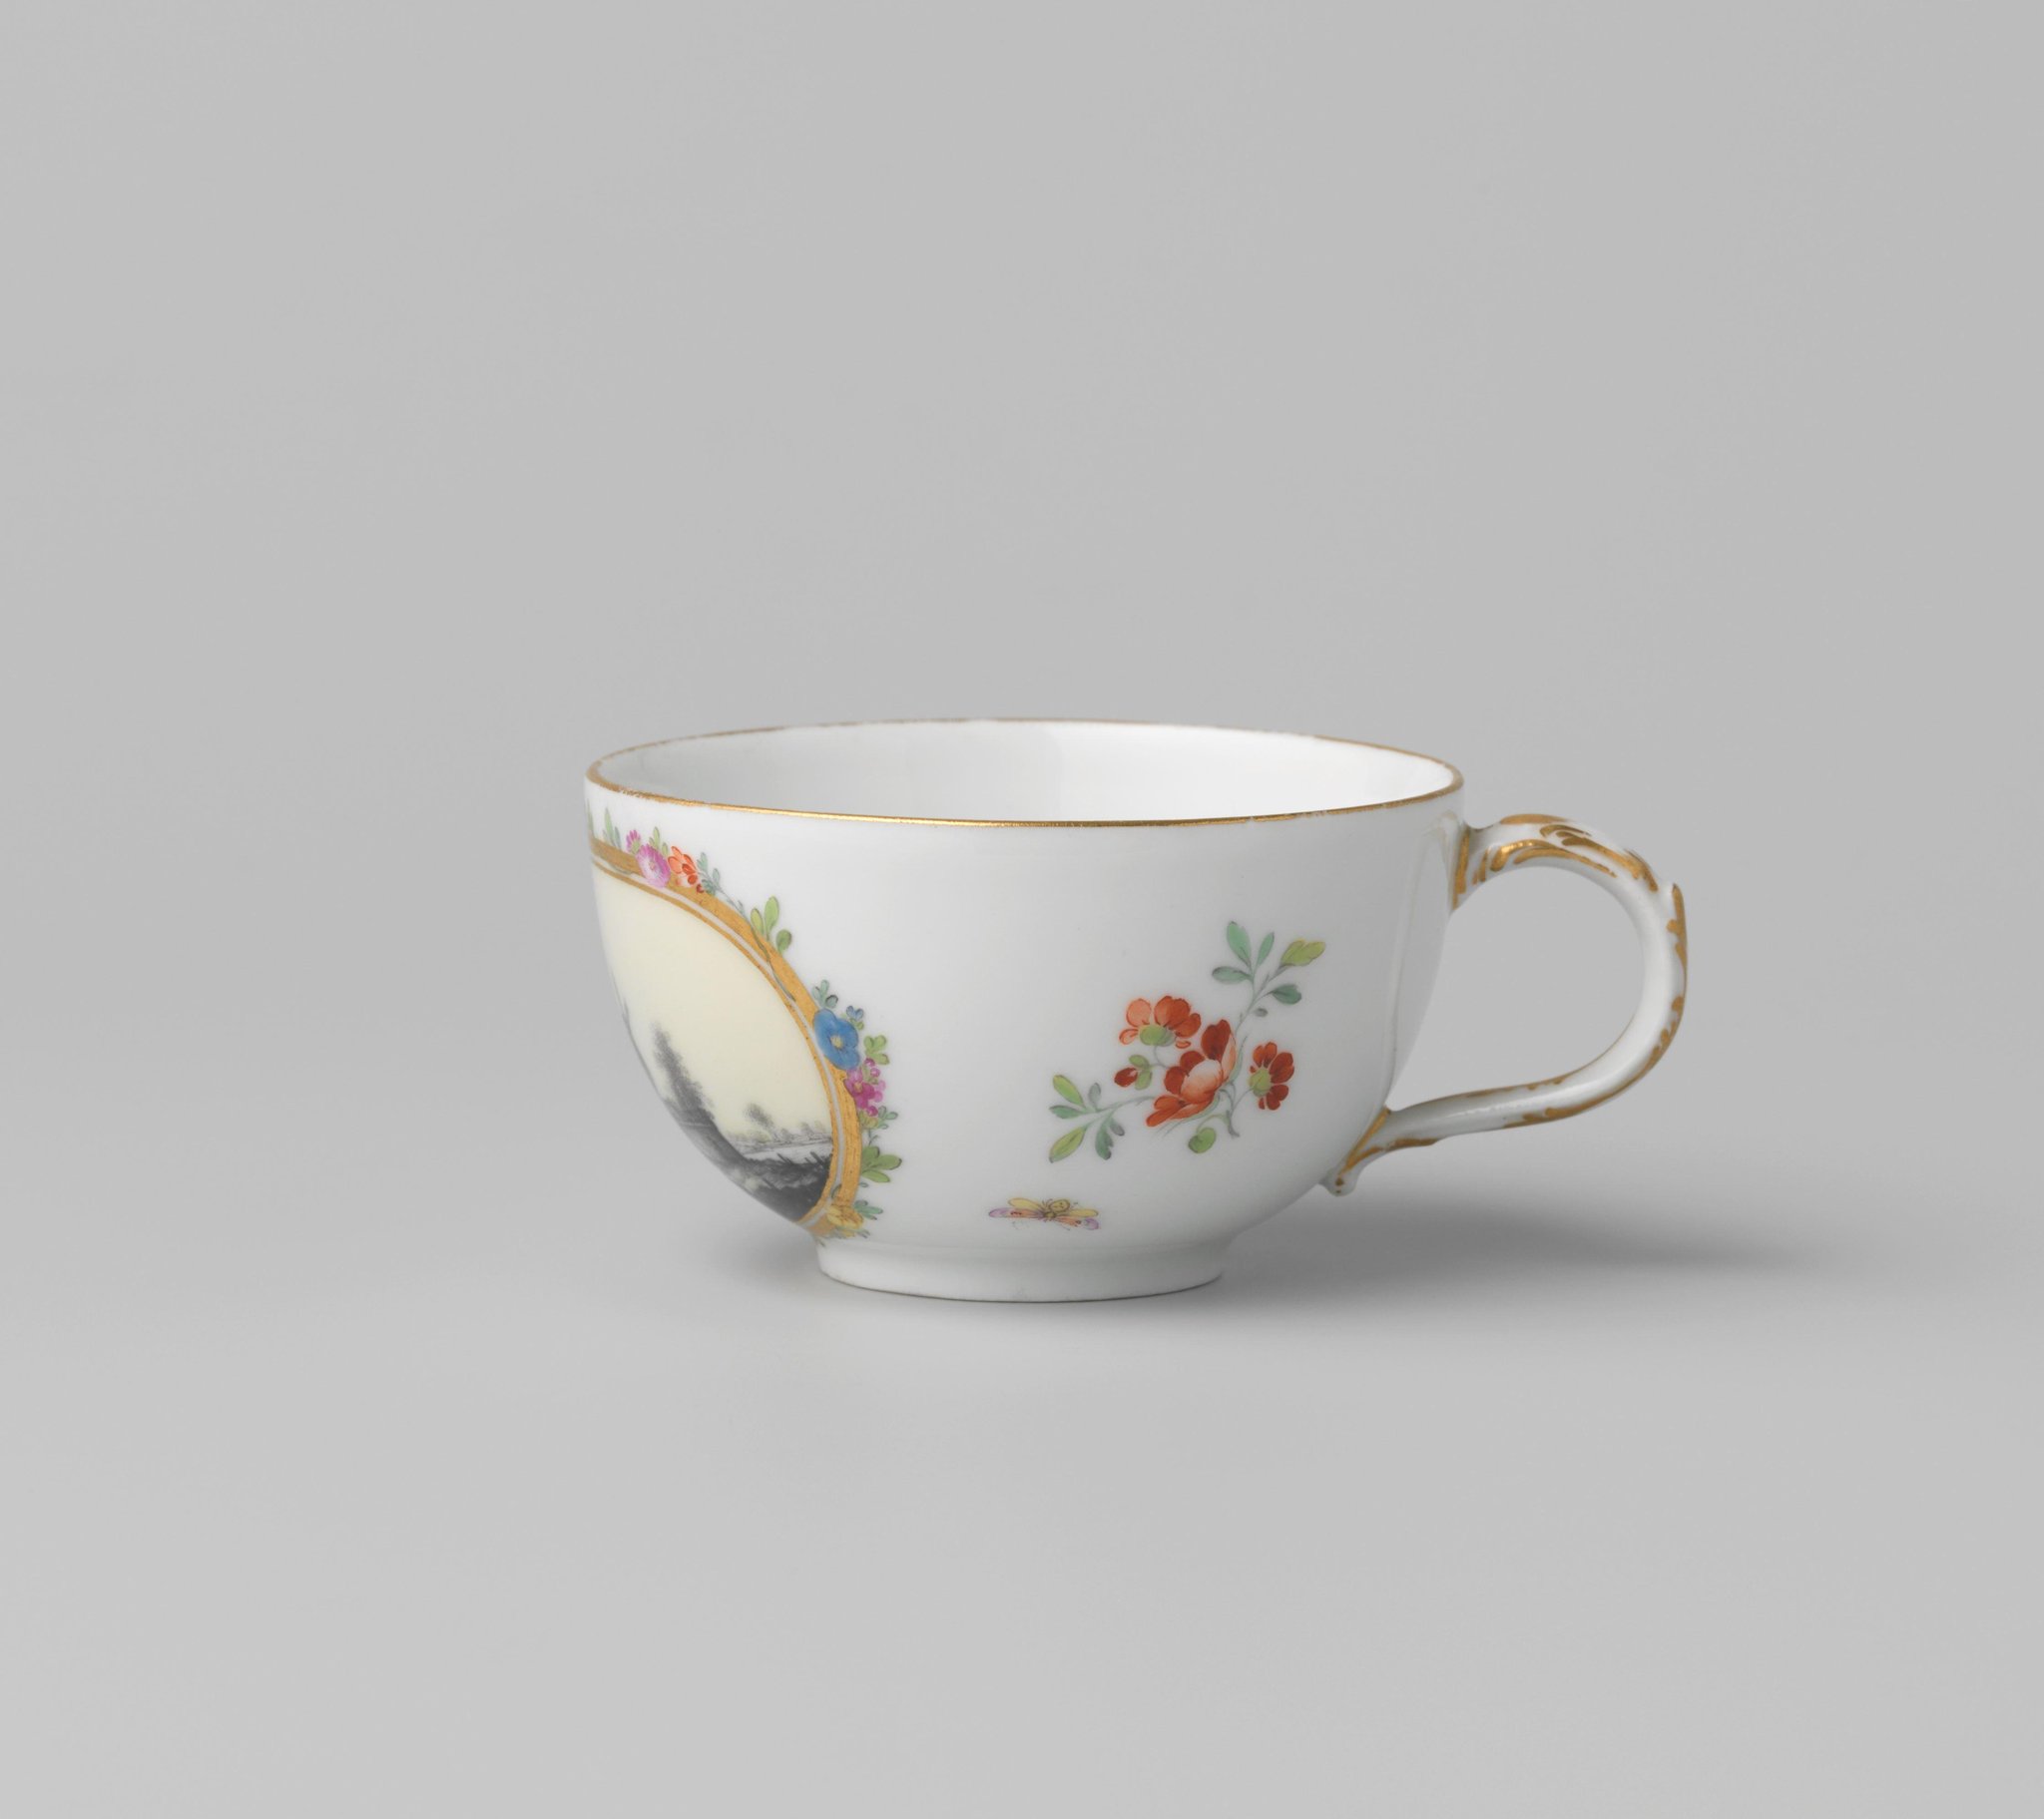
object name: service set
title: Cup with a landscape and flower sprays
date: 1780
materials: glaze, gold, paint, porcelain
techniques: firing, forming, gilding, turning, vitrification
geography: berlin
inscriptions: mark: ‘scepter/ 5’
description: Kop van porselein met een C-vormig oor, beschilderd in emailkleuren en goud. Op de buitenwand tweemaal een medaillon van bloemtakken met daarin een landschap. Hiernaast ook bloemtakken. Het oor is versierd in rocaillestijl. Gemerkt op de onderzijde met de scepter en 5.